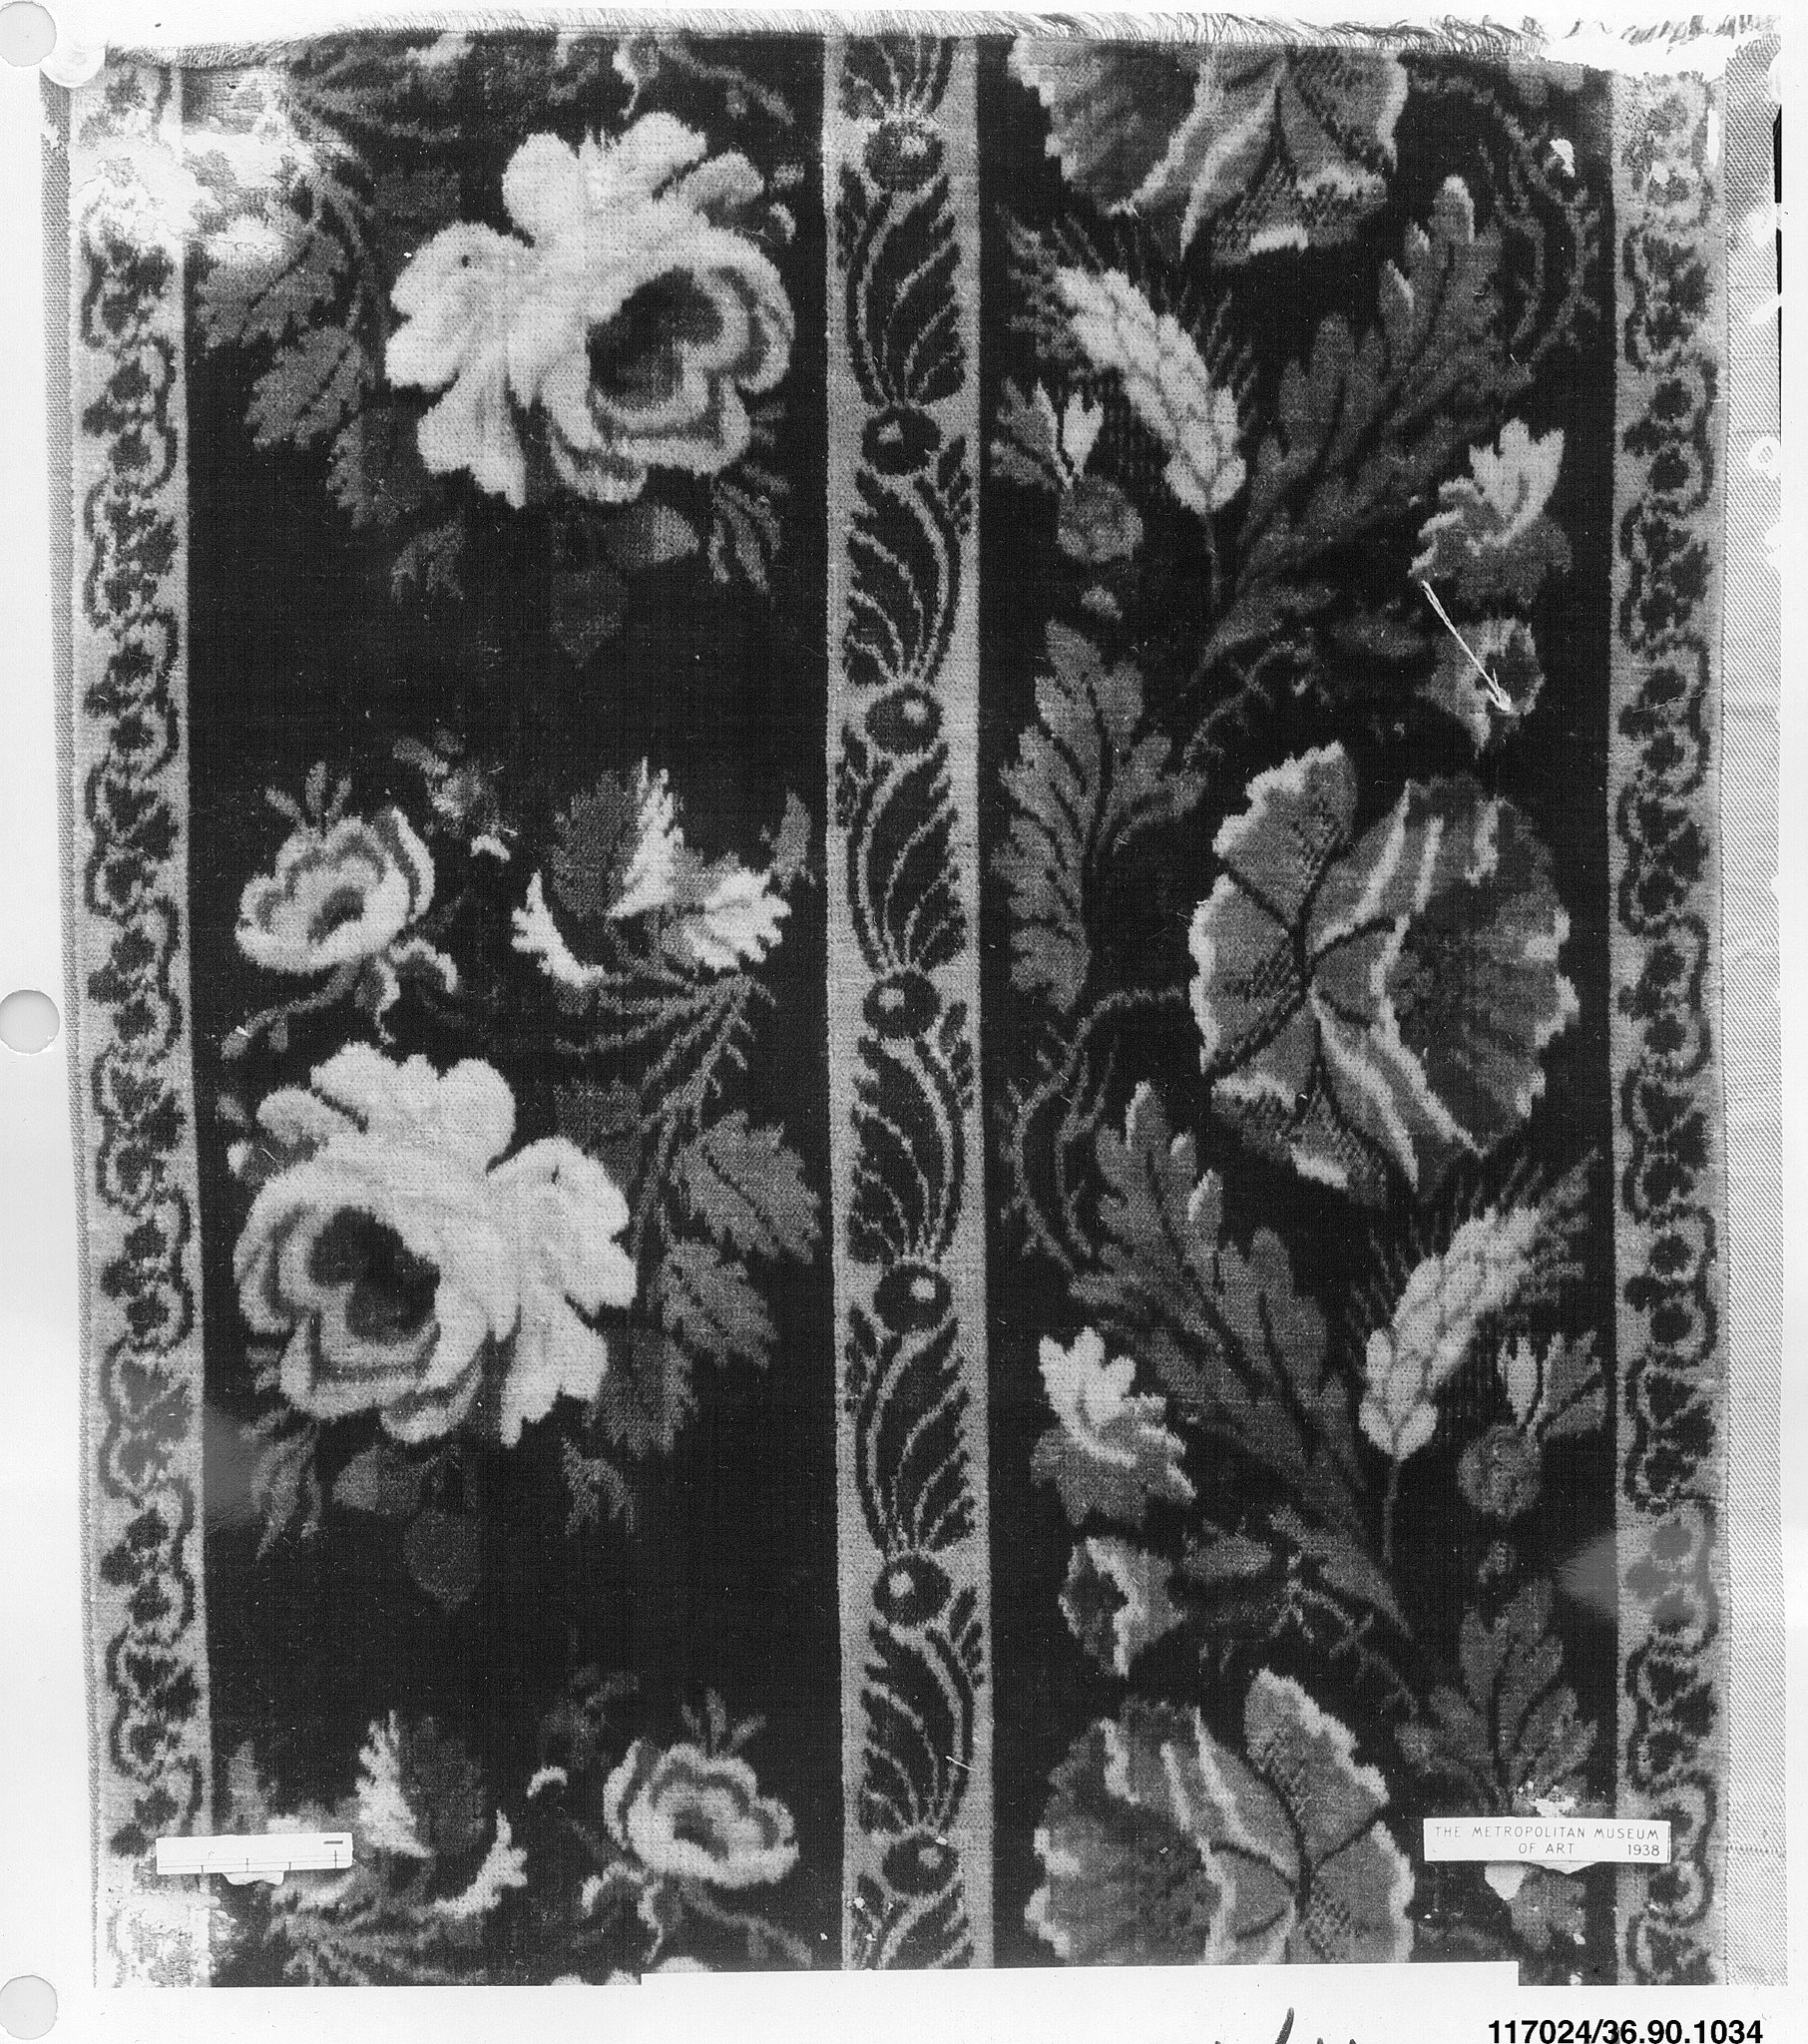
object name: piece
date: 1801-1900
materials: silk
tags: flowers,leaves